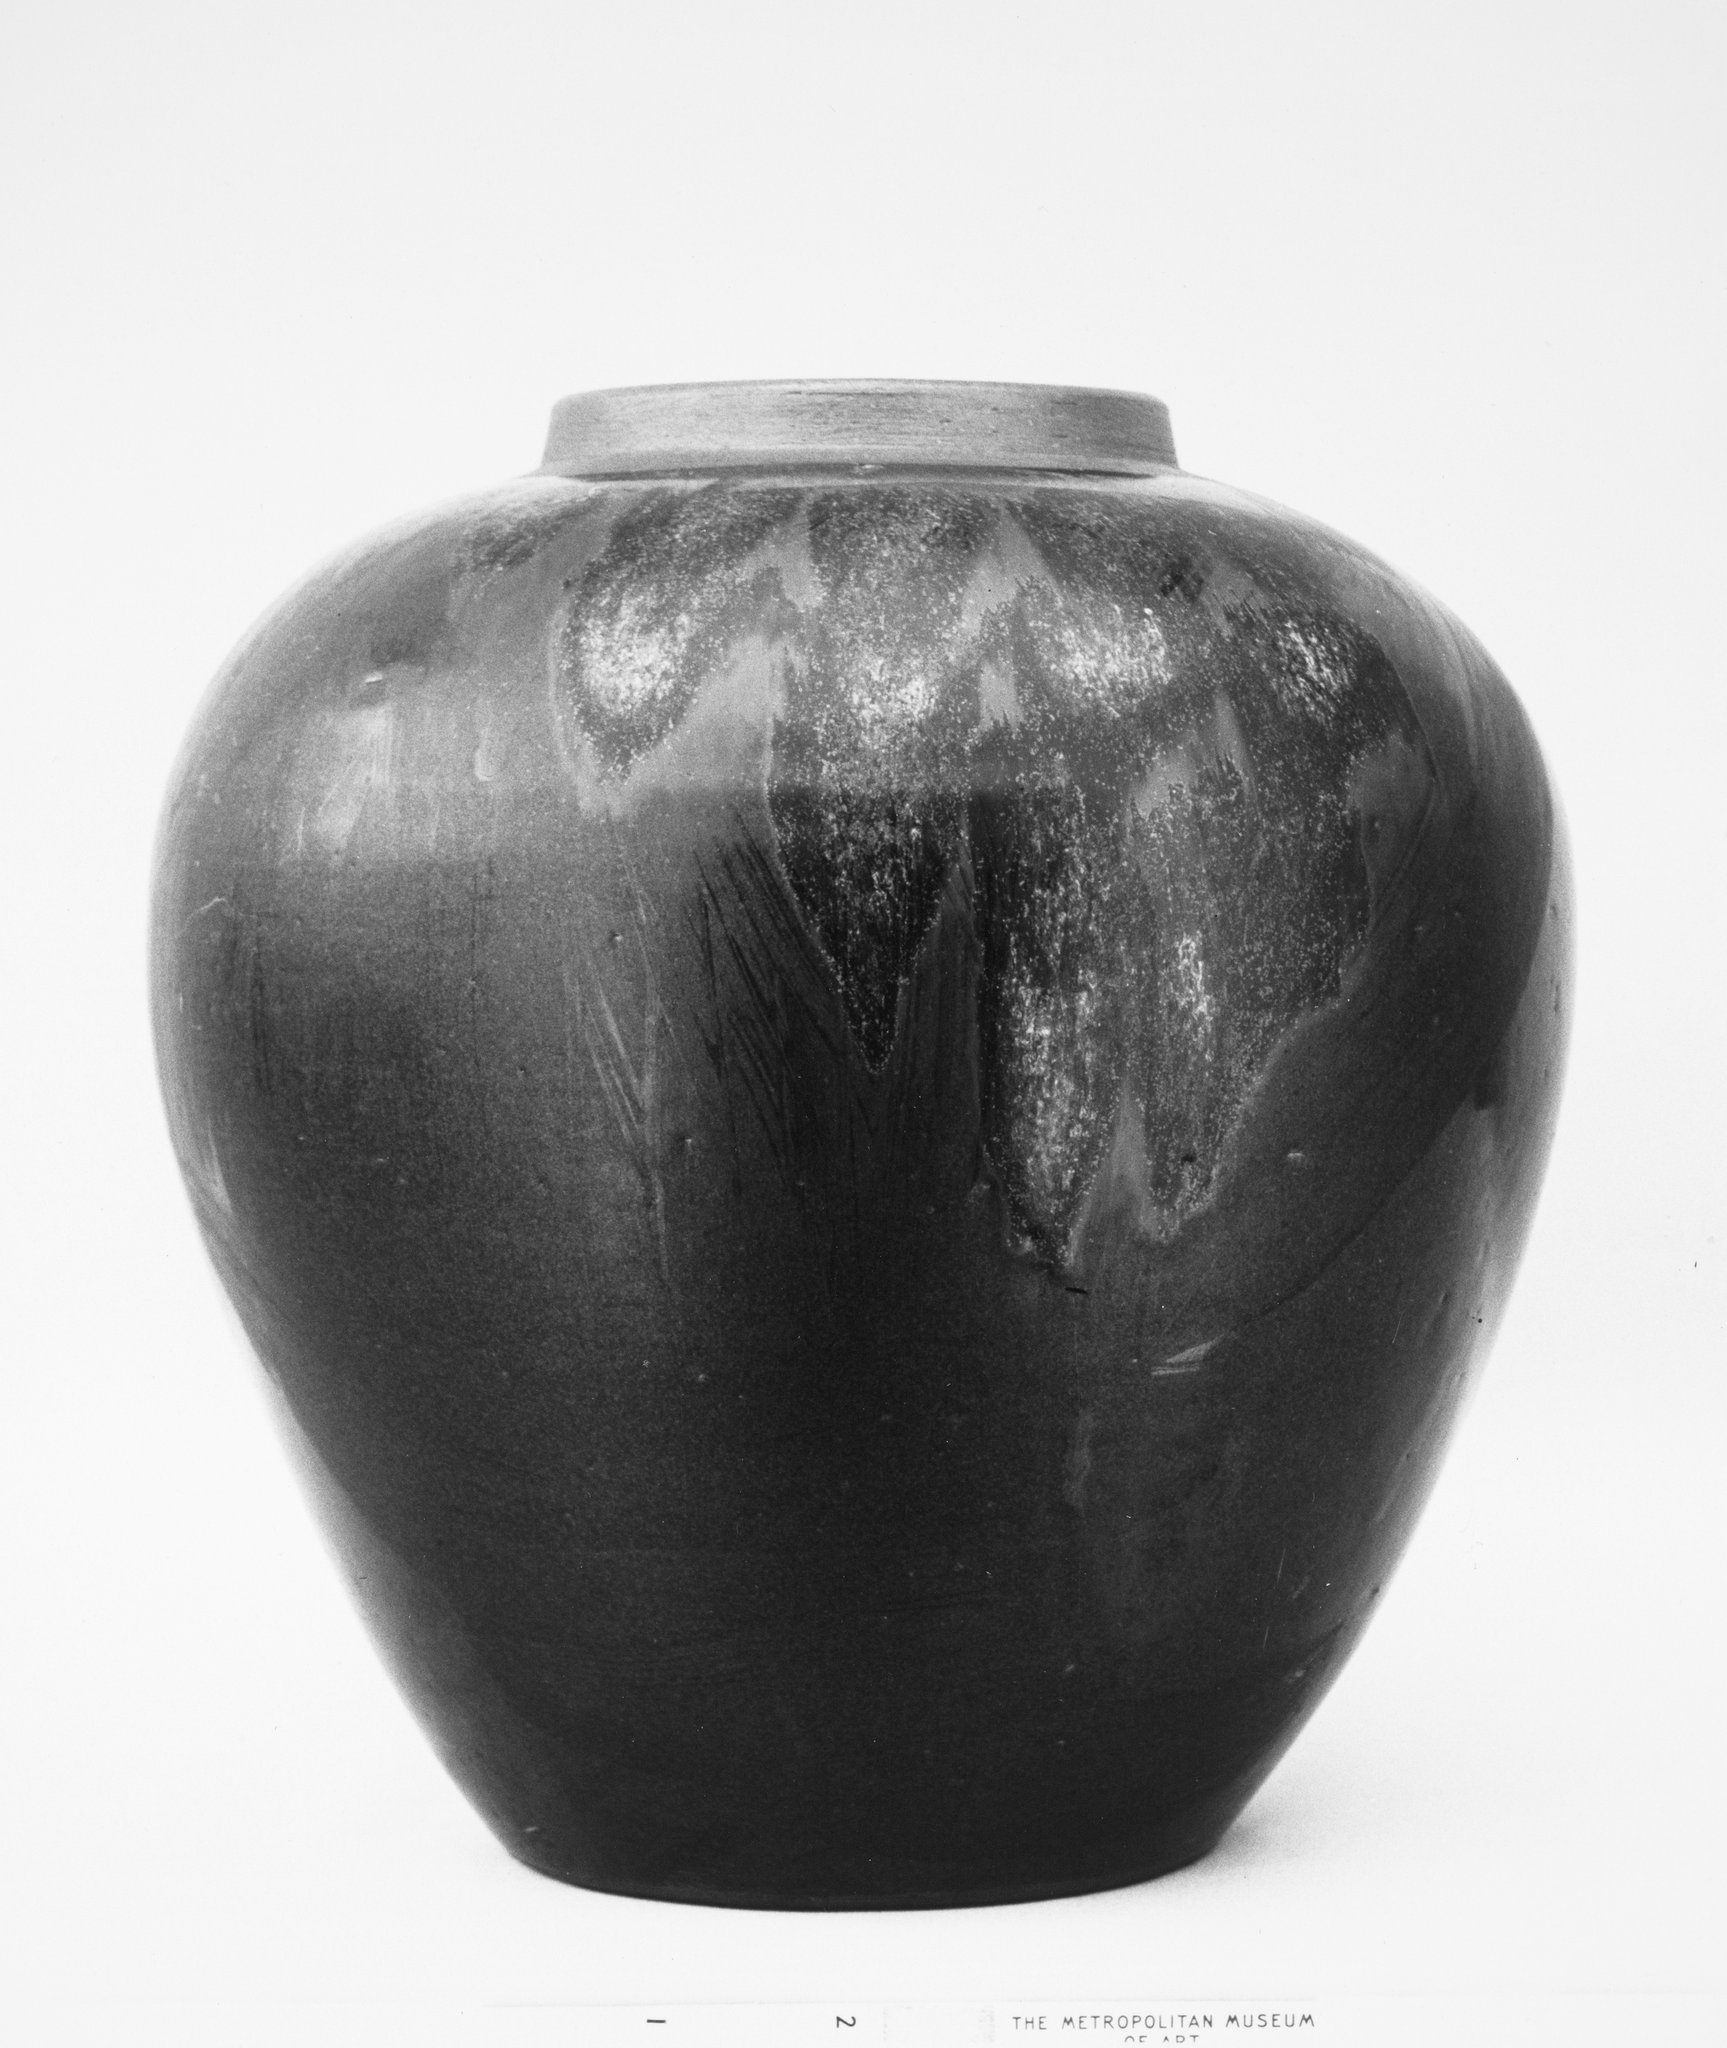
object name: jar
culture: japanese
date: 1801-1900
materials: clay, glaze